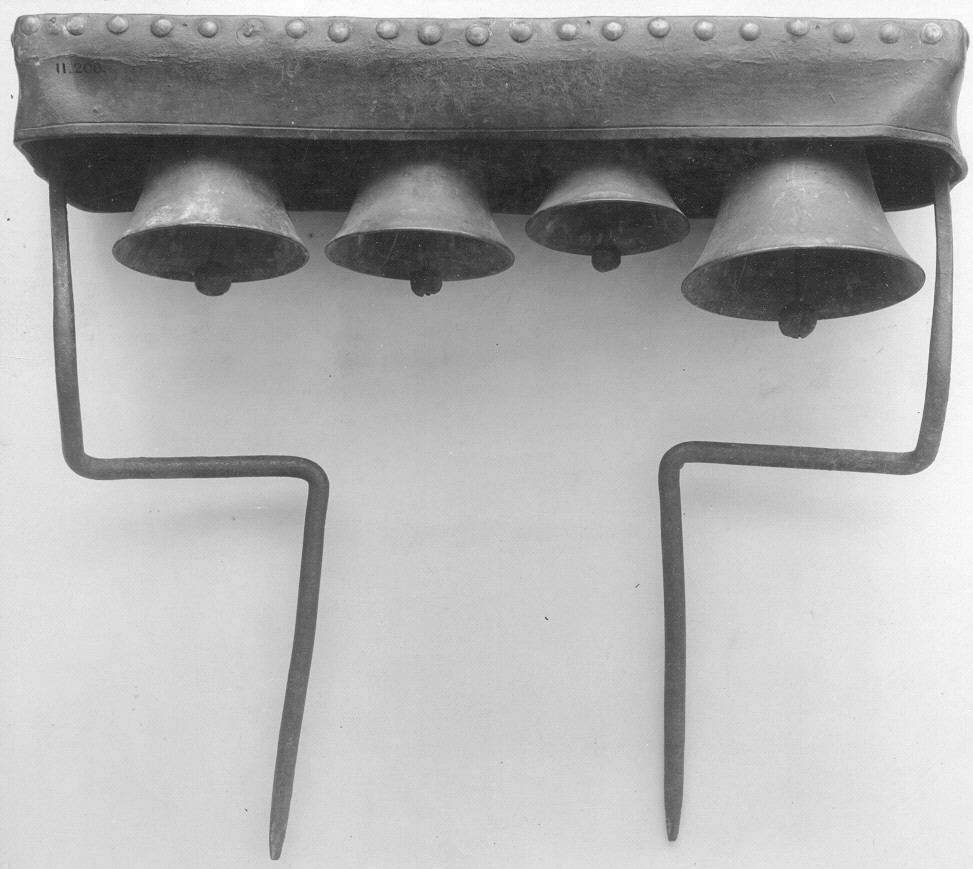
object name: bell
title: Bells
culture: british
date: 1825-1889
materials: bronze, leather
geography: england